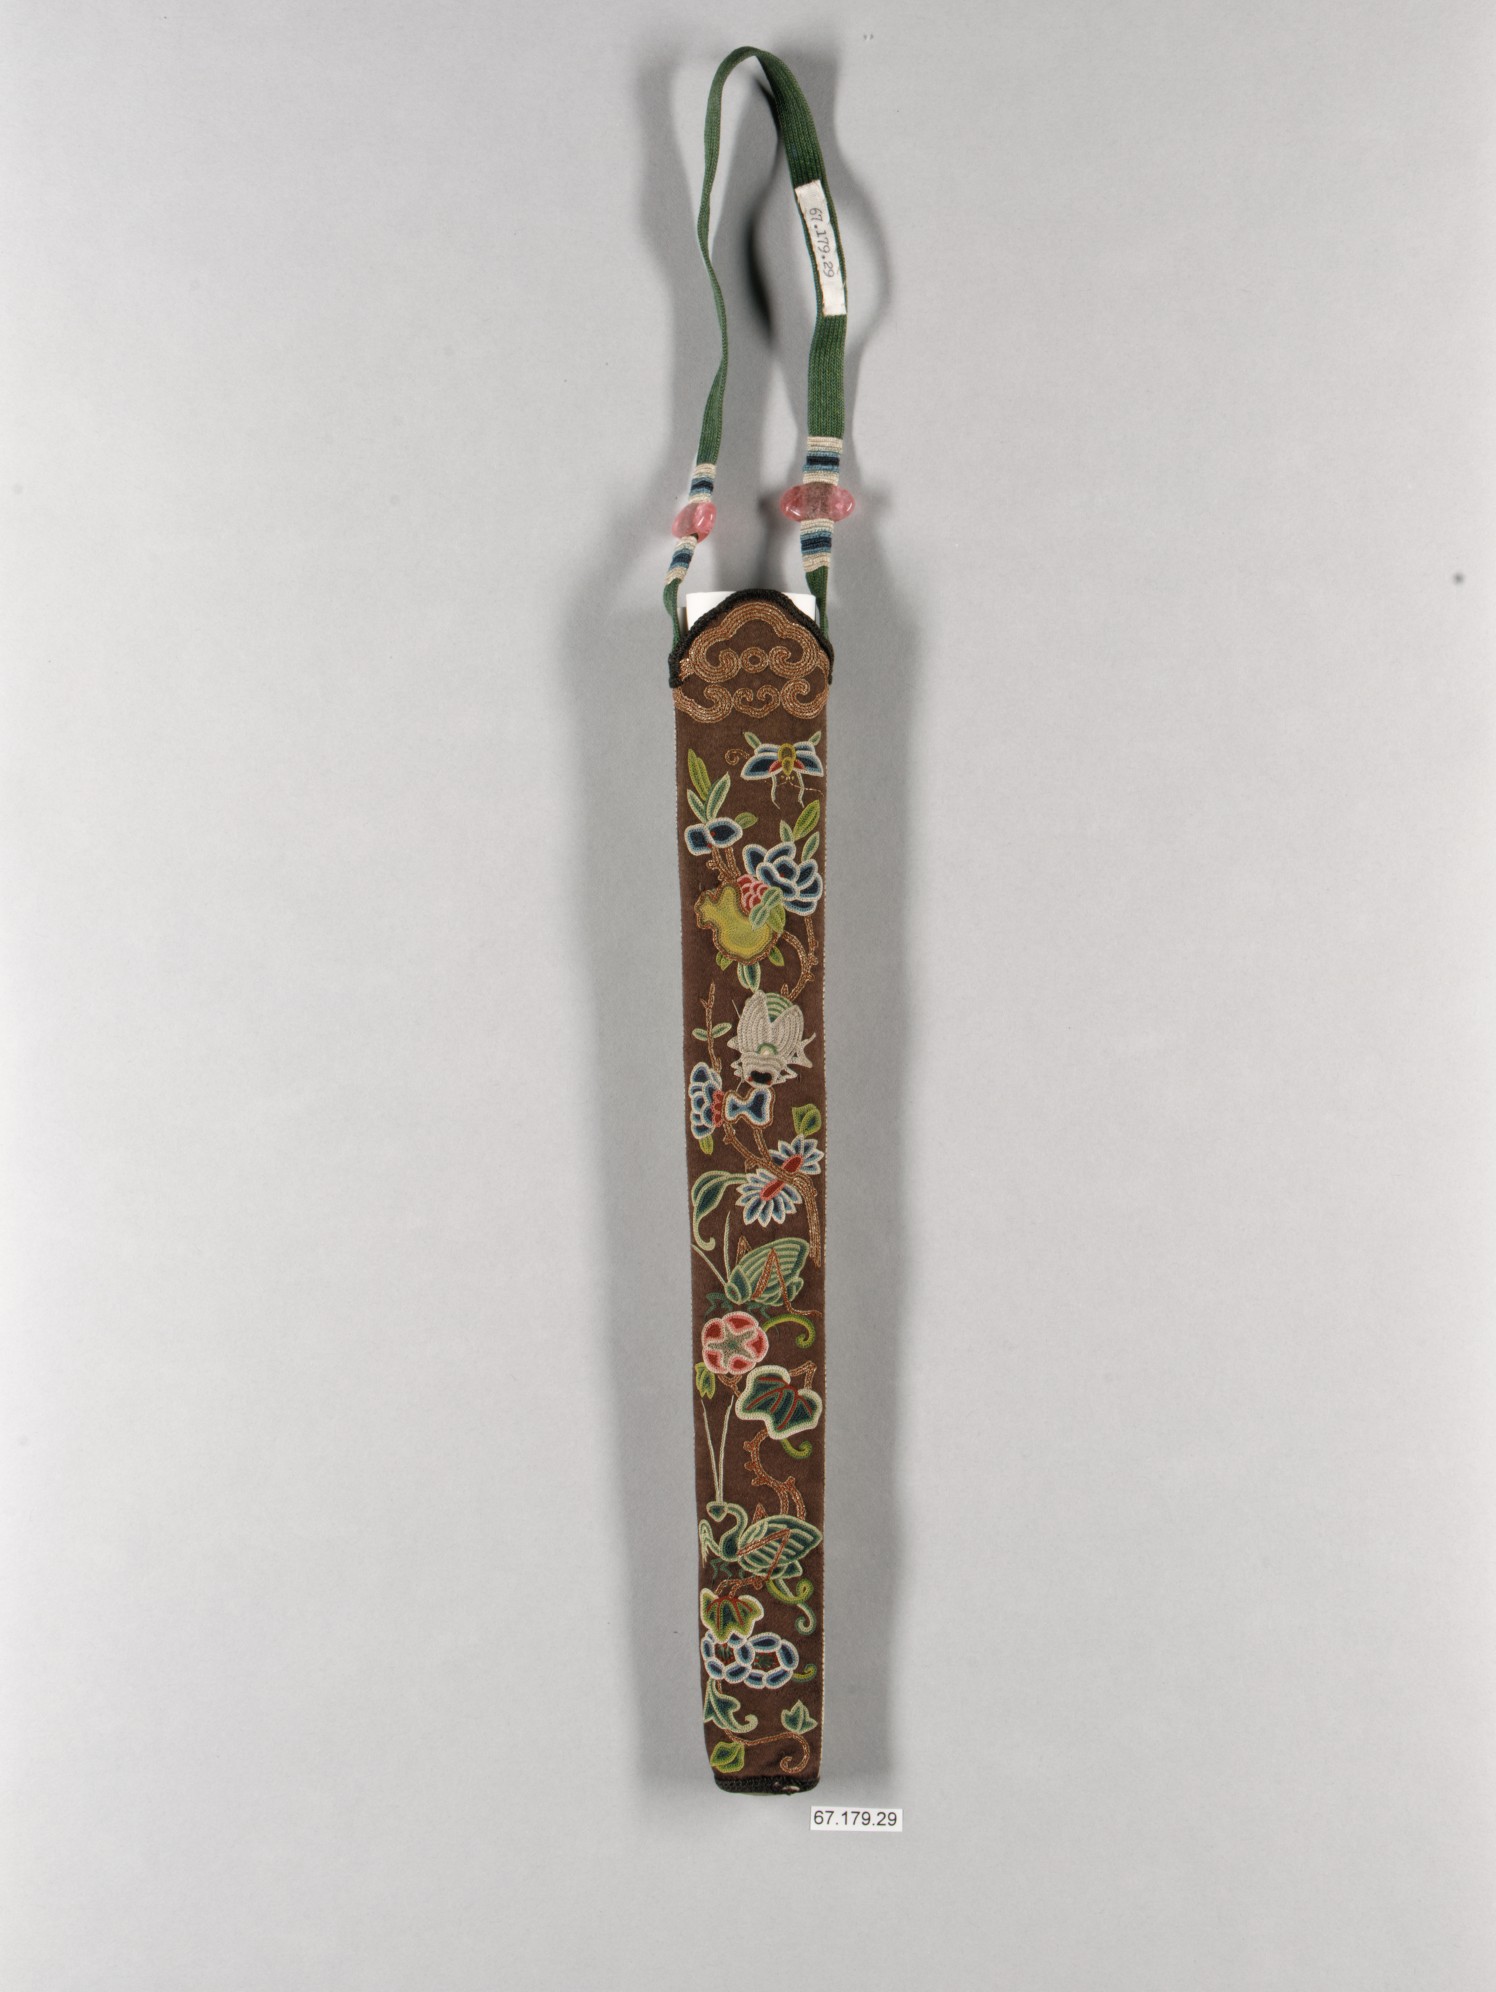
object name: fan case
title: Fan Case with Flowers and Insects on a Brown Background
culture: chinese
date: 1834-1866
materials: metal thread, silk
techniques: embroidery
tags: insects,flowers